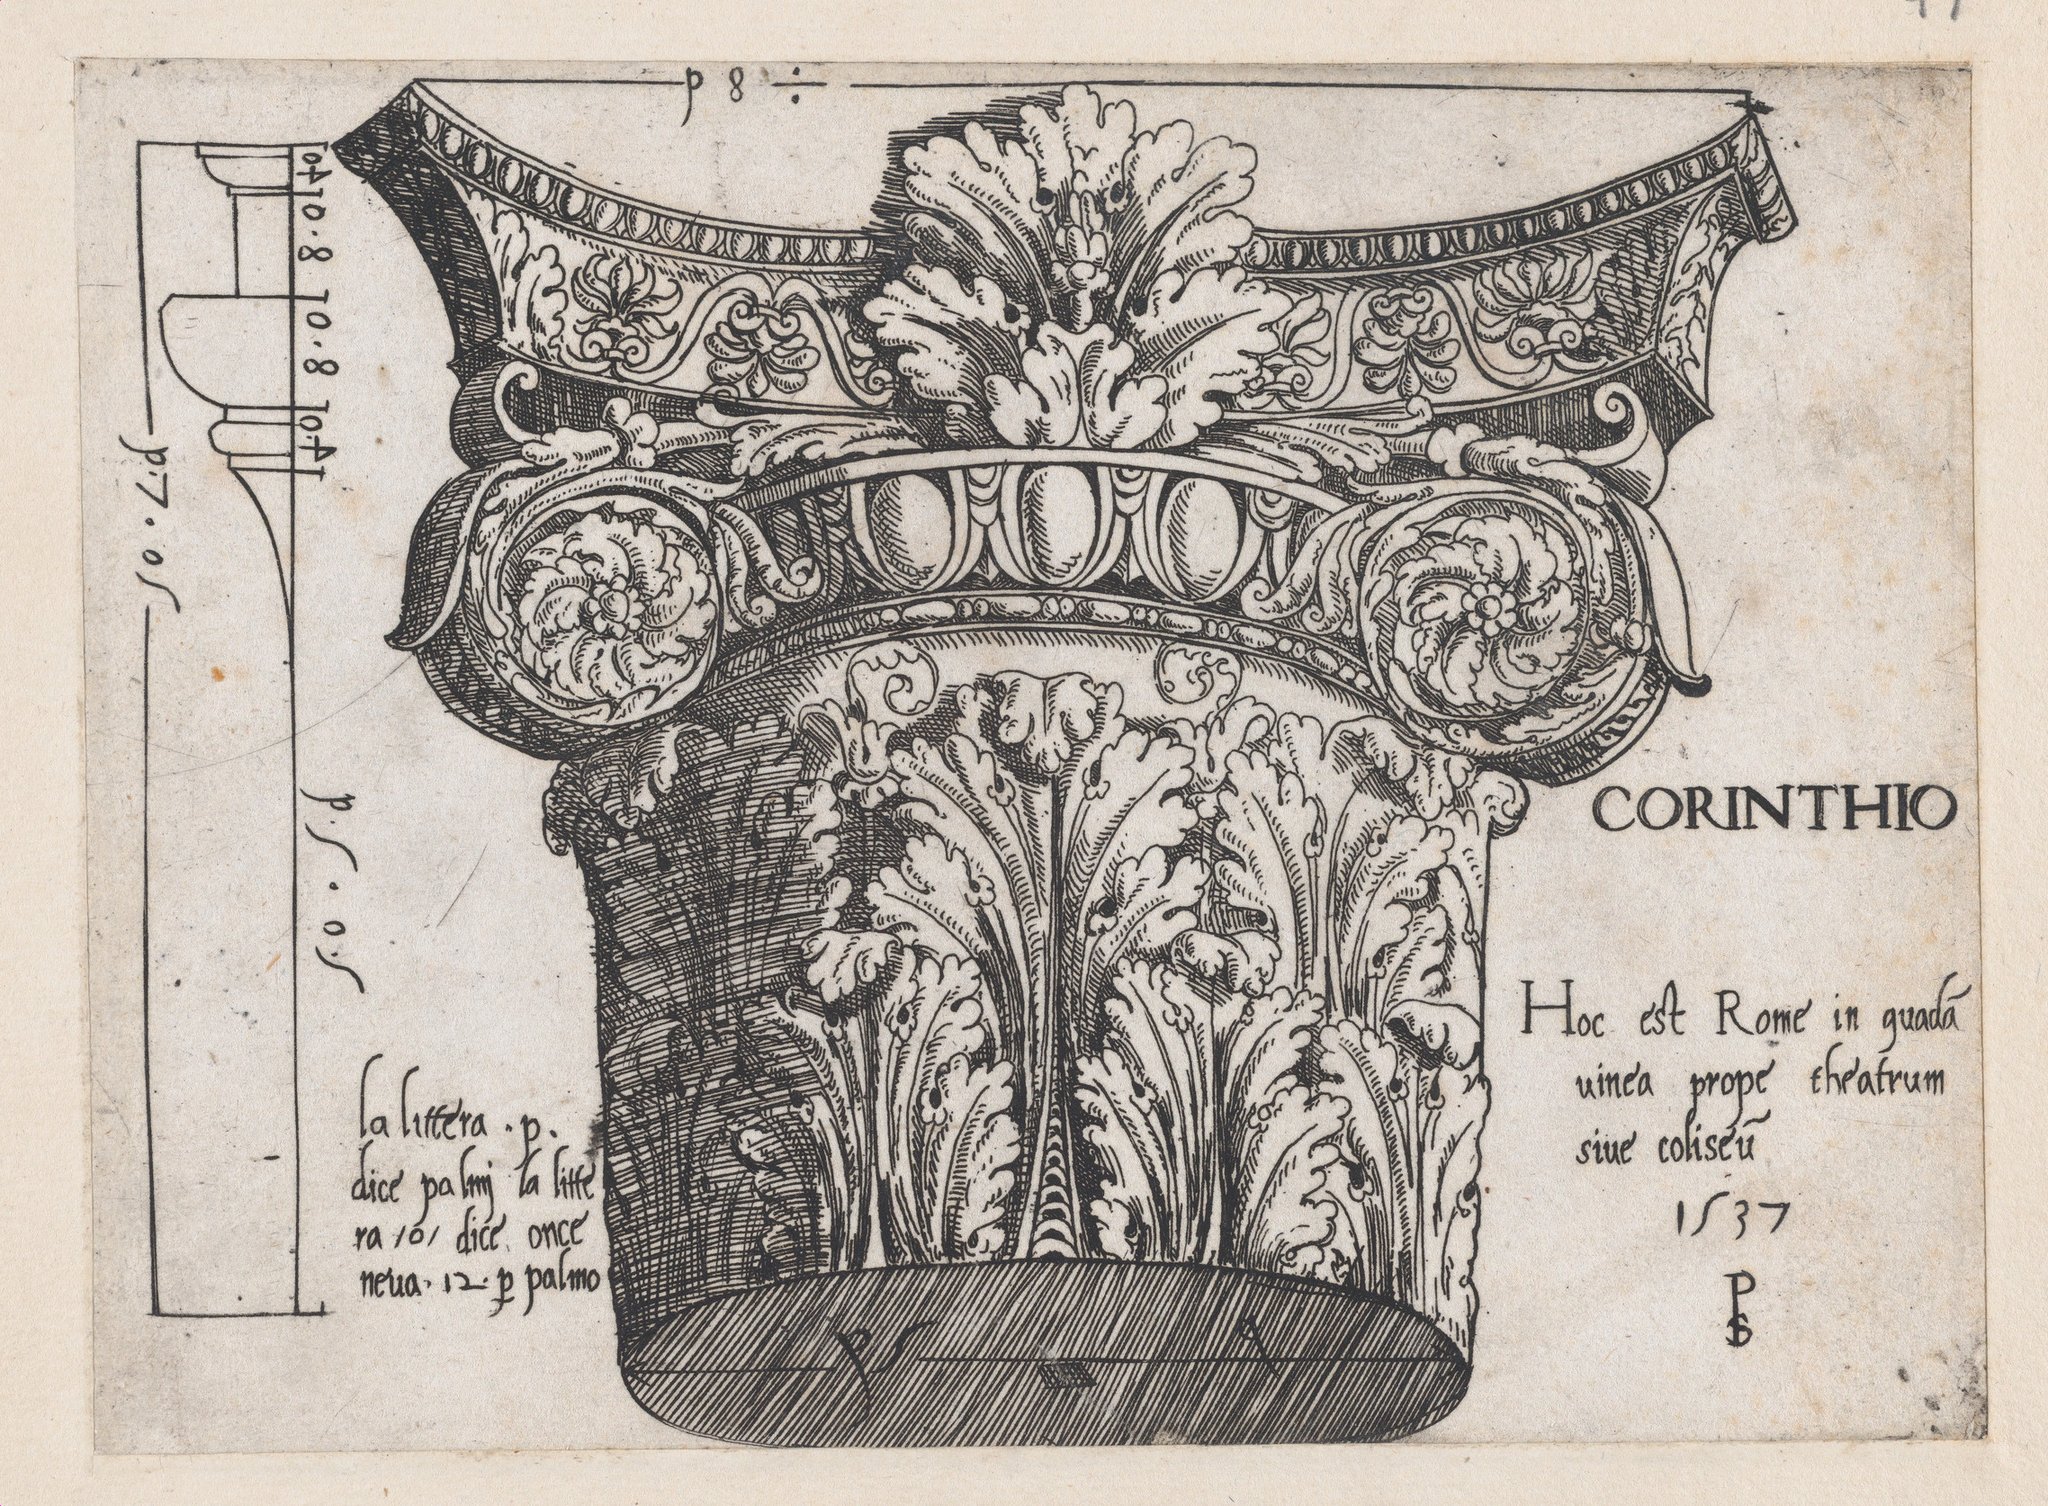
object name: print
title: Corinthian capital, from "Speculum Romanae Magnificentiae"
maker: master ps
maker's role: artist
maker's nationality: italian or french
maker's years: 1530-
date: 1537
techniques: engraving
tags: capitals